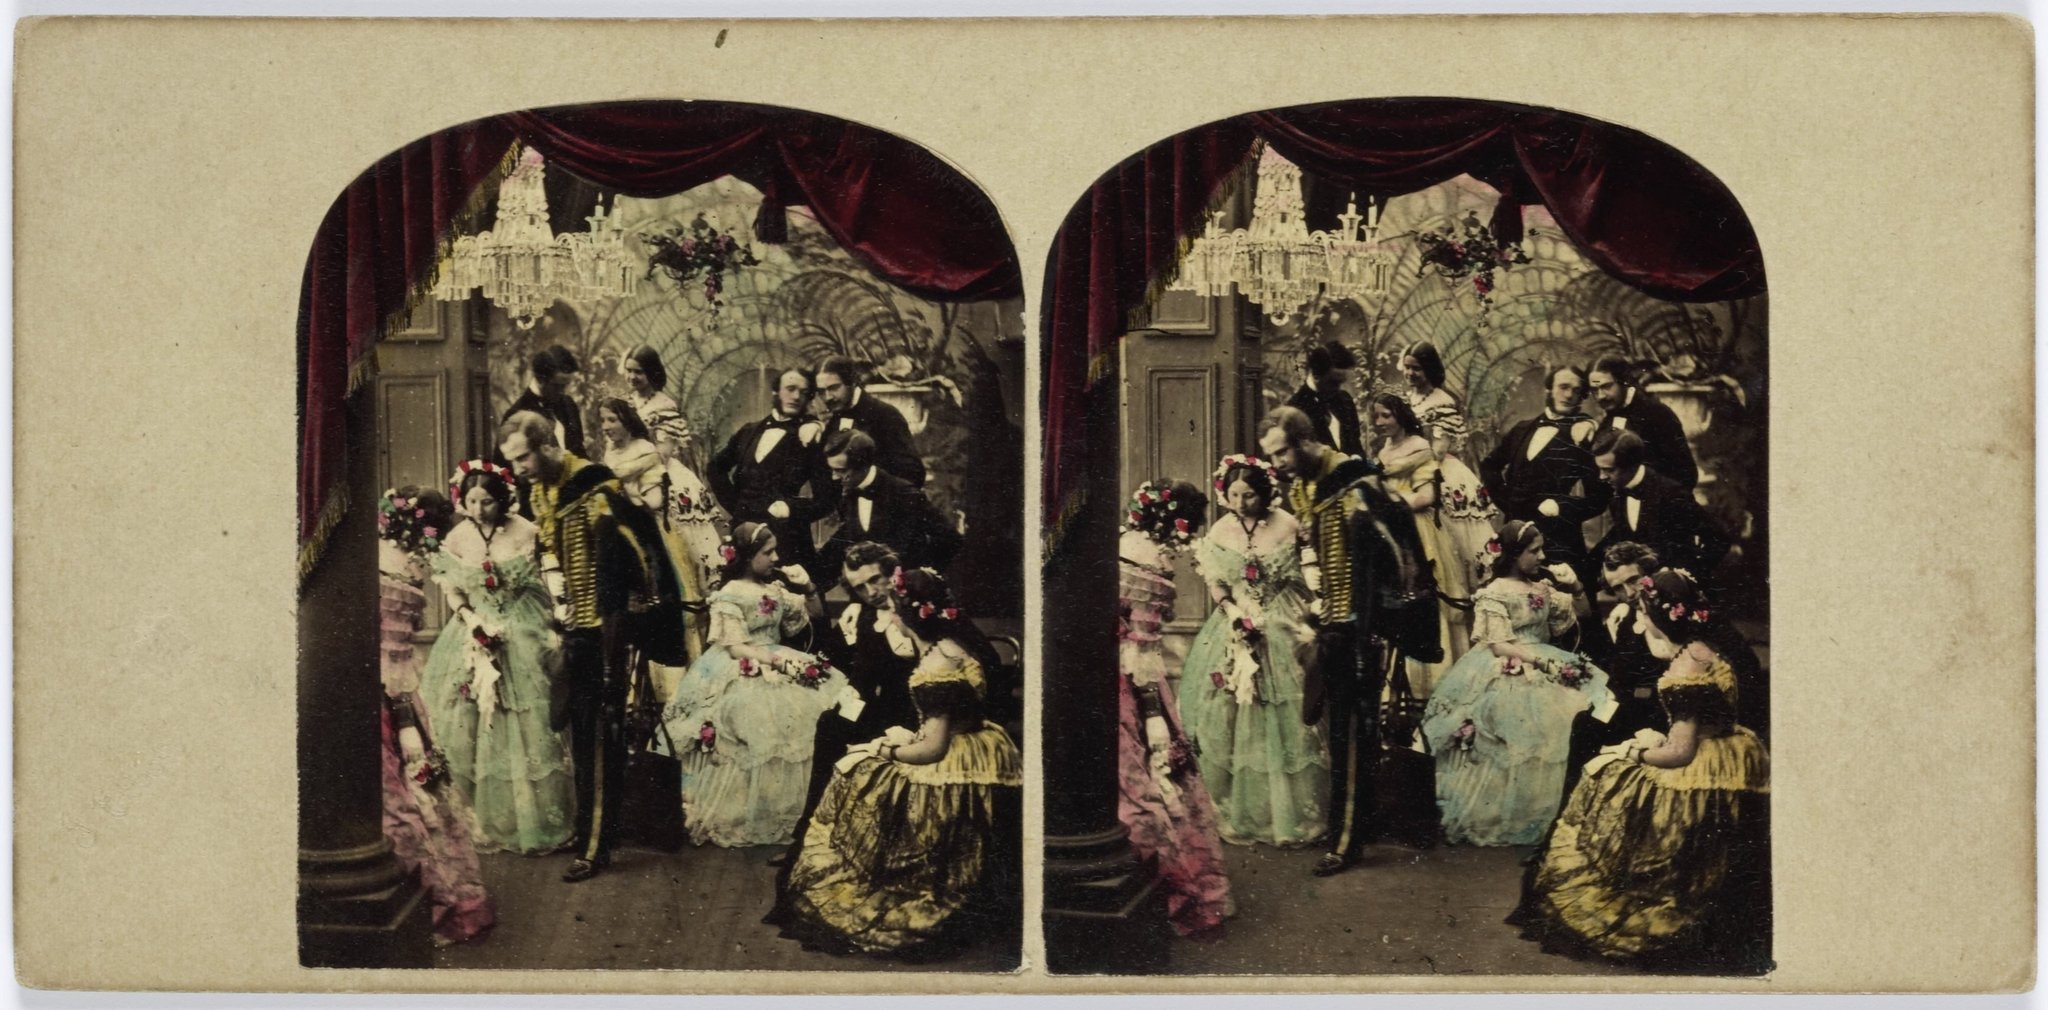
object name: stereograph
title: Ball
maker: james elliott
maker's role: publisher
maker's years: 1832-1900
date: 1856-1861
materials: cardboard, paper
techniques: albumen print, hand coloring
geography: london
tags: ball, formal dance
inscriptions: number: ‘21’, stamp: ‘J. C. Meerburg/ Leijden’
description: James Eliott (1832-1900), albuminedruk, met de hand ingekleurd, ca. 1855-1870